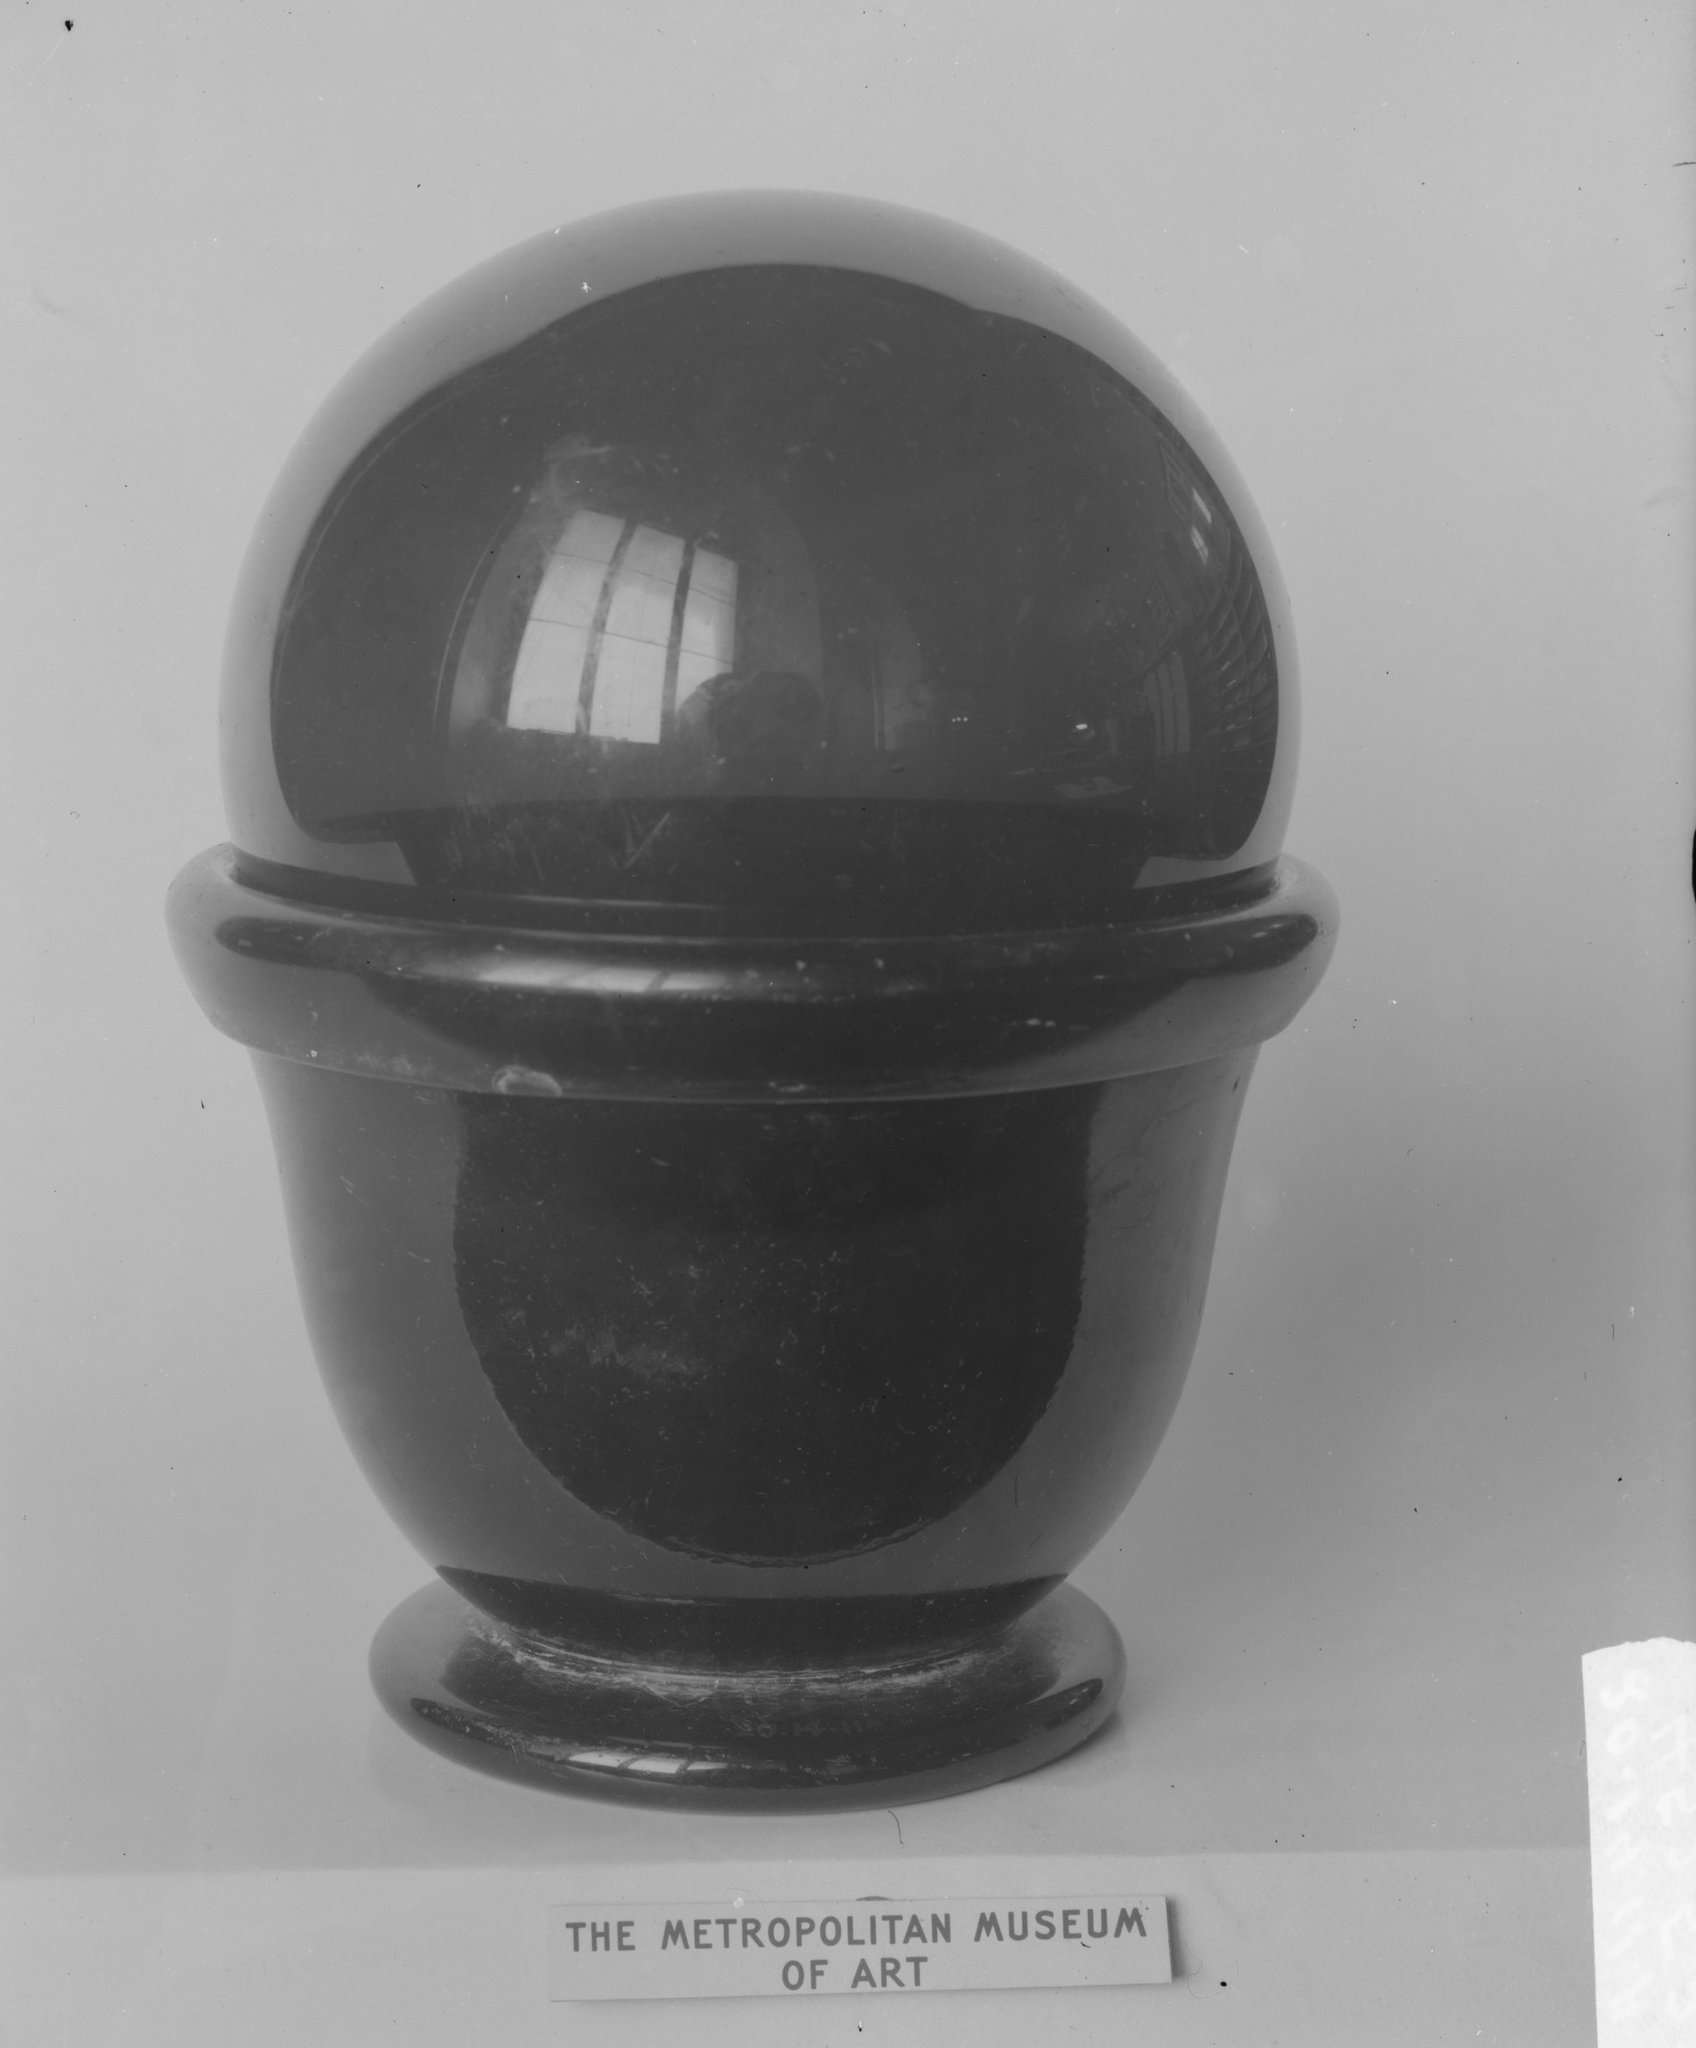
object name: bowl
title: Covered Bowl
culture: american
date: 1800-1830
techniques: glassblowing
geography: united states